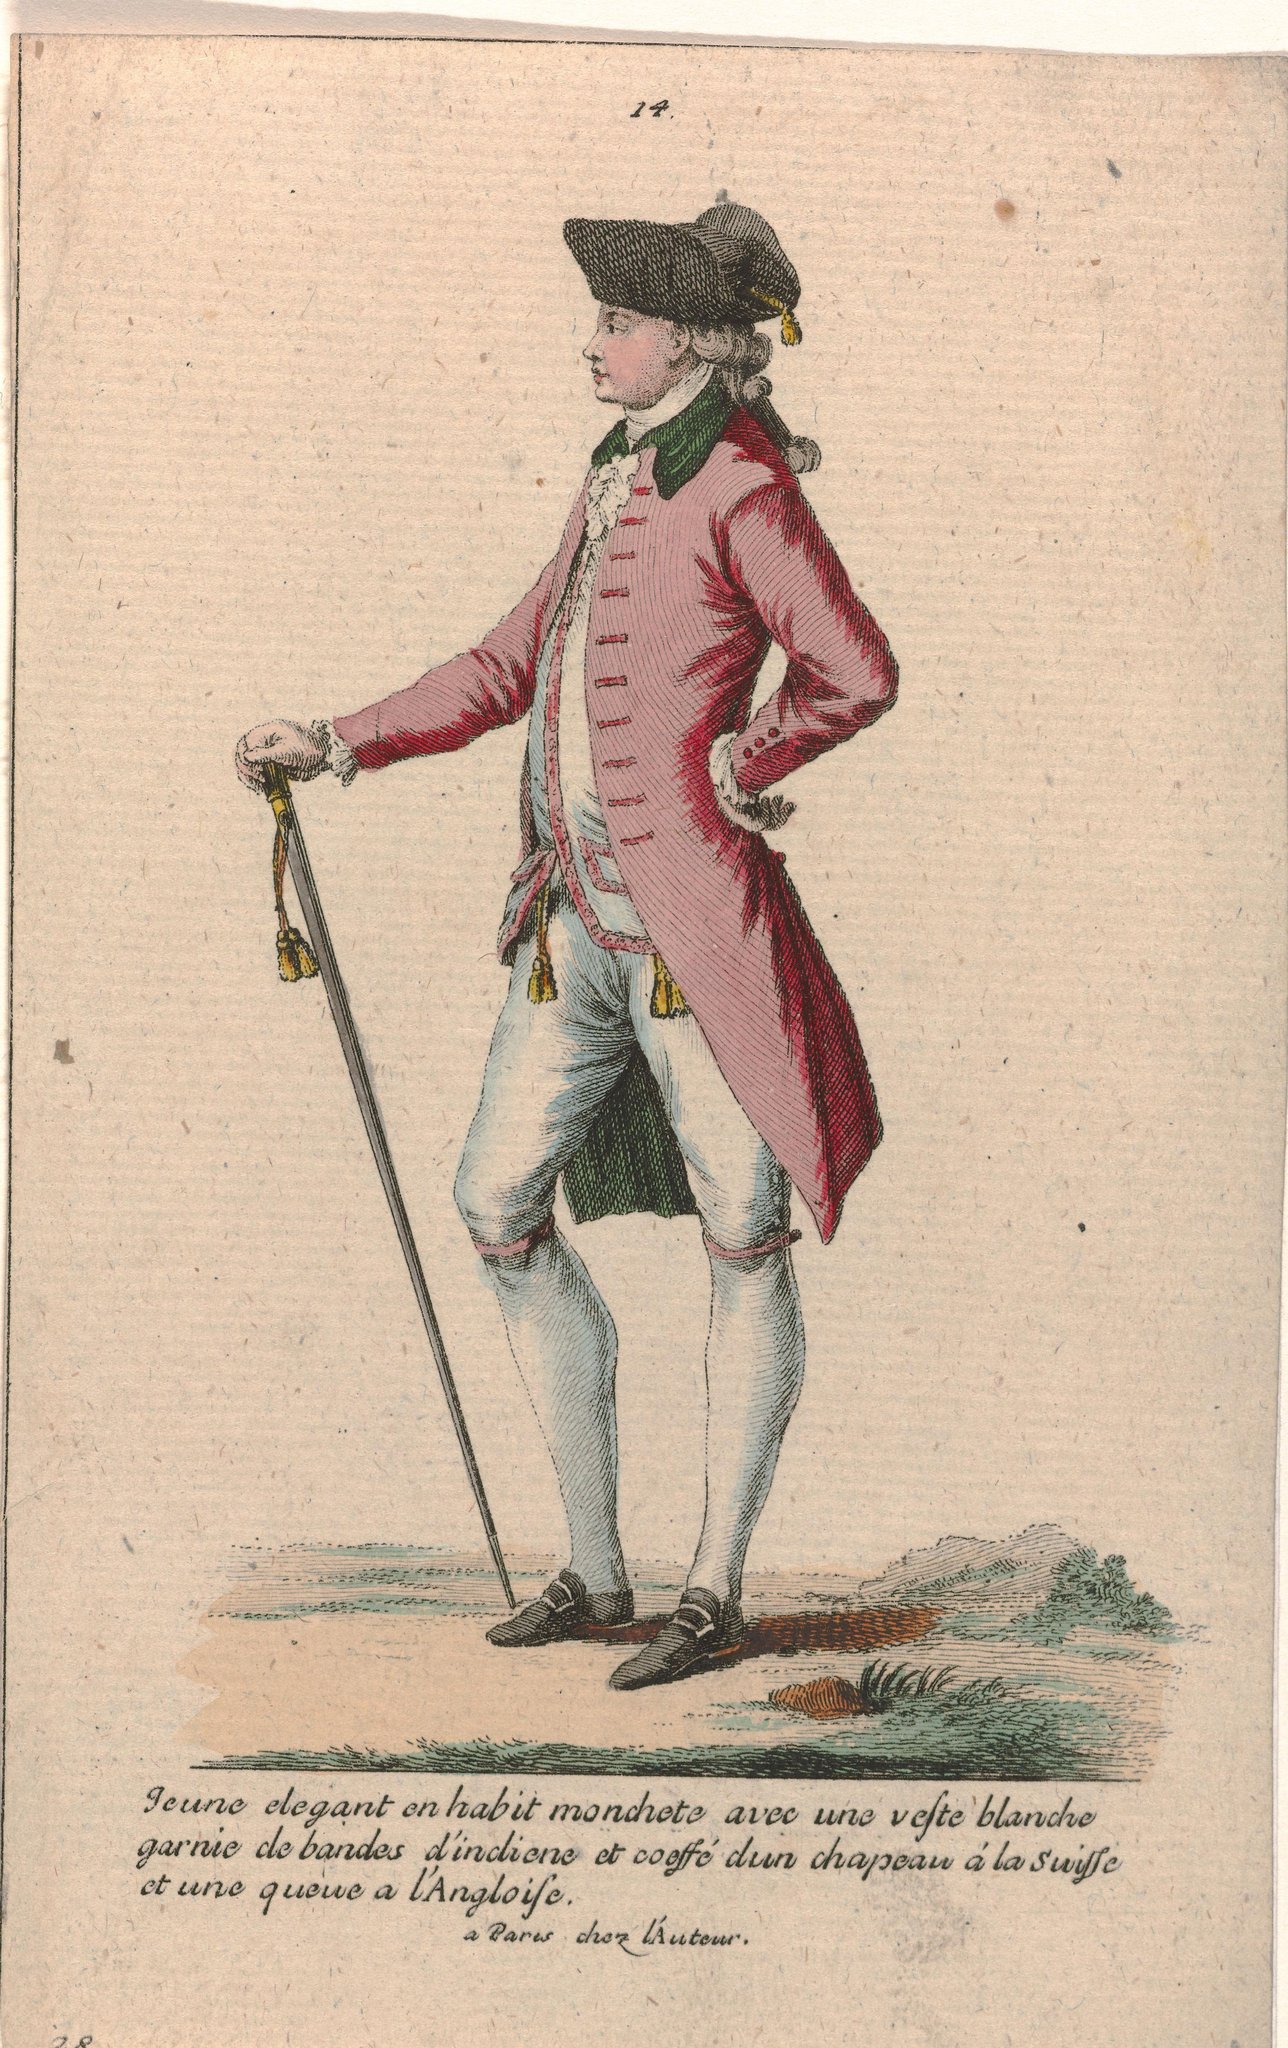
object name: fashion print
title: Gallerie des Modes et Costumes Français, 1785, nr. 14, nr. 28, Kopie naar J 52 : Jeune élégant en habit monchet (...)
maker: pierre gleich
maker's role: print maker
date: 1785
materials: paper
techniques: engraving, hand coloring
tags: clothing for the upper part of the body (vest) (+ men's clothes), head-gear, neck-gear: jabot (+ men's clothes), styles of hairdress, fashion plates, trousers, breeches, etc. (breeches) (+ men's clothes), walking-stick, staff, cane (+ men's clothes)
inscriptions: caption: ‘Jeune elegant en habit monchete avec une veste blanche garnie de bandes d'indiene et coeffé d'un chapeau à la Suisse et une queue a l'Angloise.’, caption: ‘a Paris chez l'Auteur’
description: Elegante jongeman gekleed in een 'habit moncheté' op een wit vest, afgezet met band van 'indienne' (beschilderde of bedrukte katoen). Kniebroek.Gerimpelde jabot en manchetten. Op het hoofd een 'chapeau à la Suisse'. Het haar is omwikkeld door band van zwarte stof: 'queue à l'Angloise'. Verdere accessoires: breloques, wandelstok met kwasten, schoenen met gespen. Kopie naar J 52 uit serie J. 9e Cahier des Costumes Français, 3e Suite d'Habillemens à la mode, Gallerie des Modes et Costumes Français.